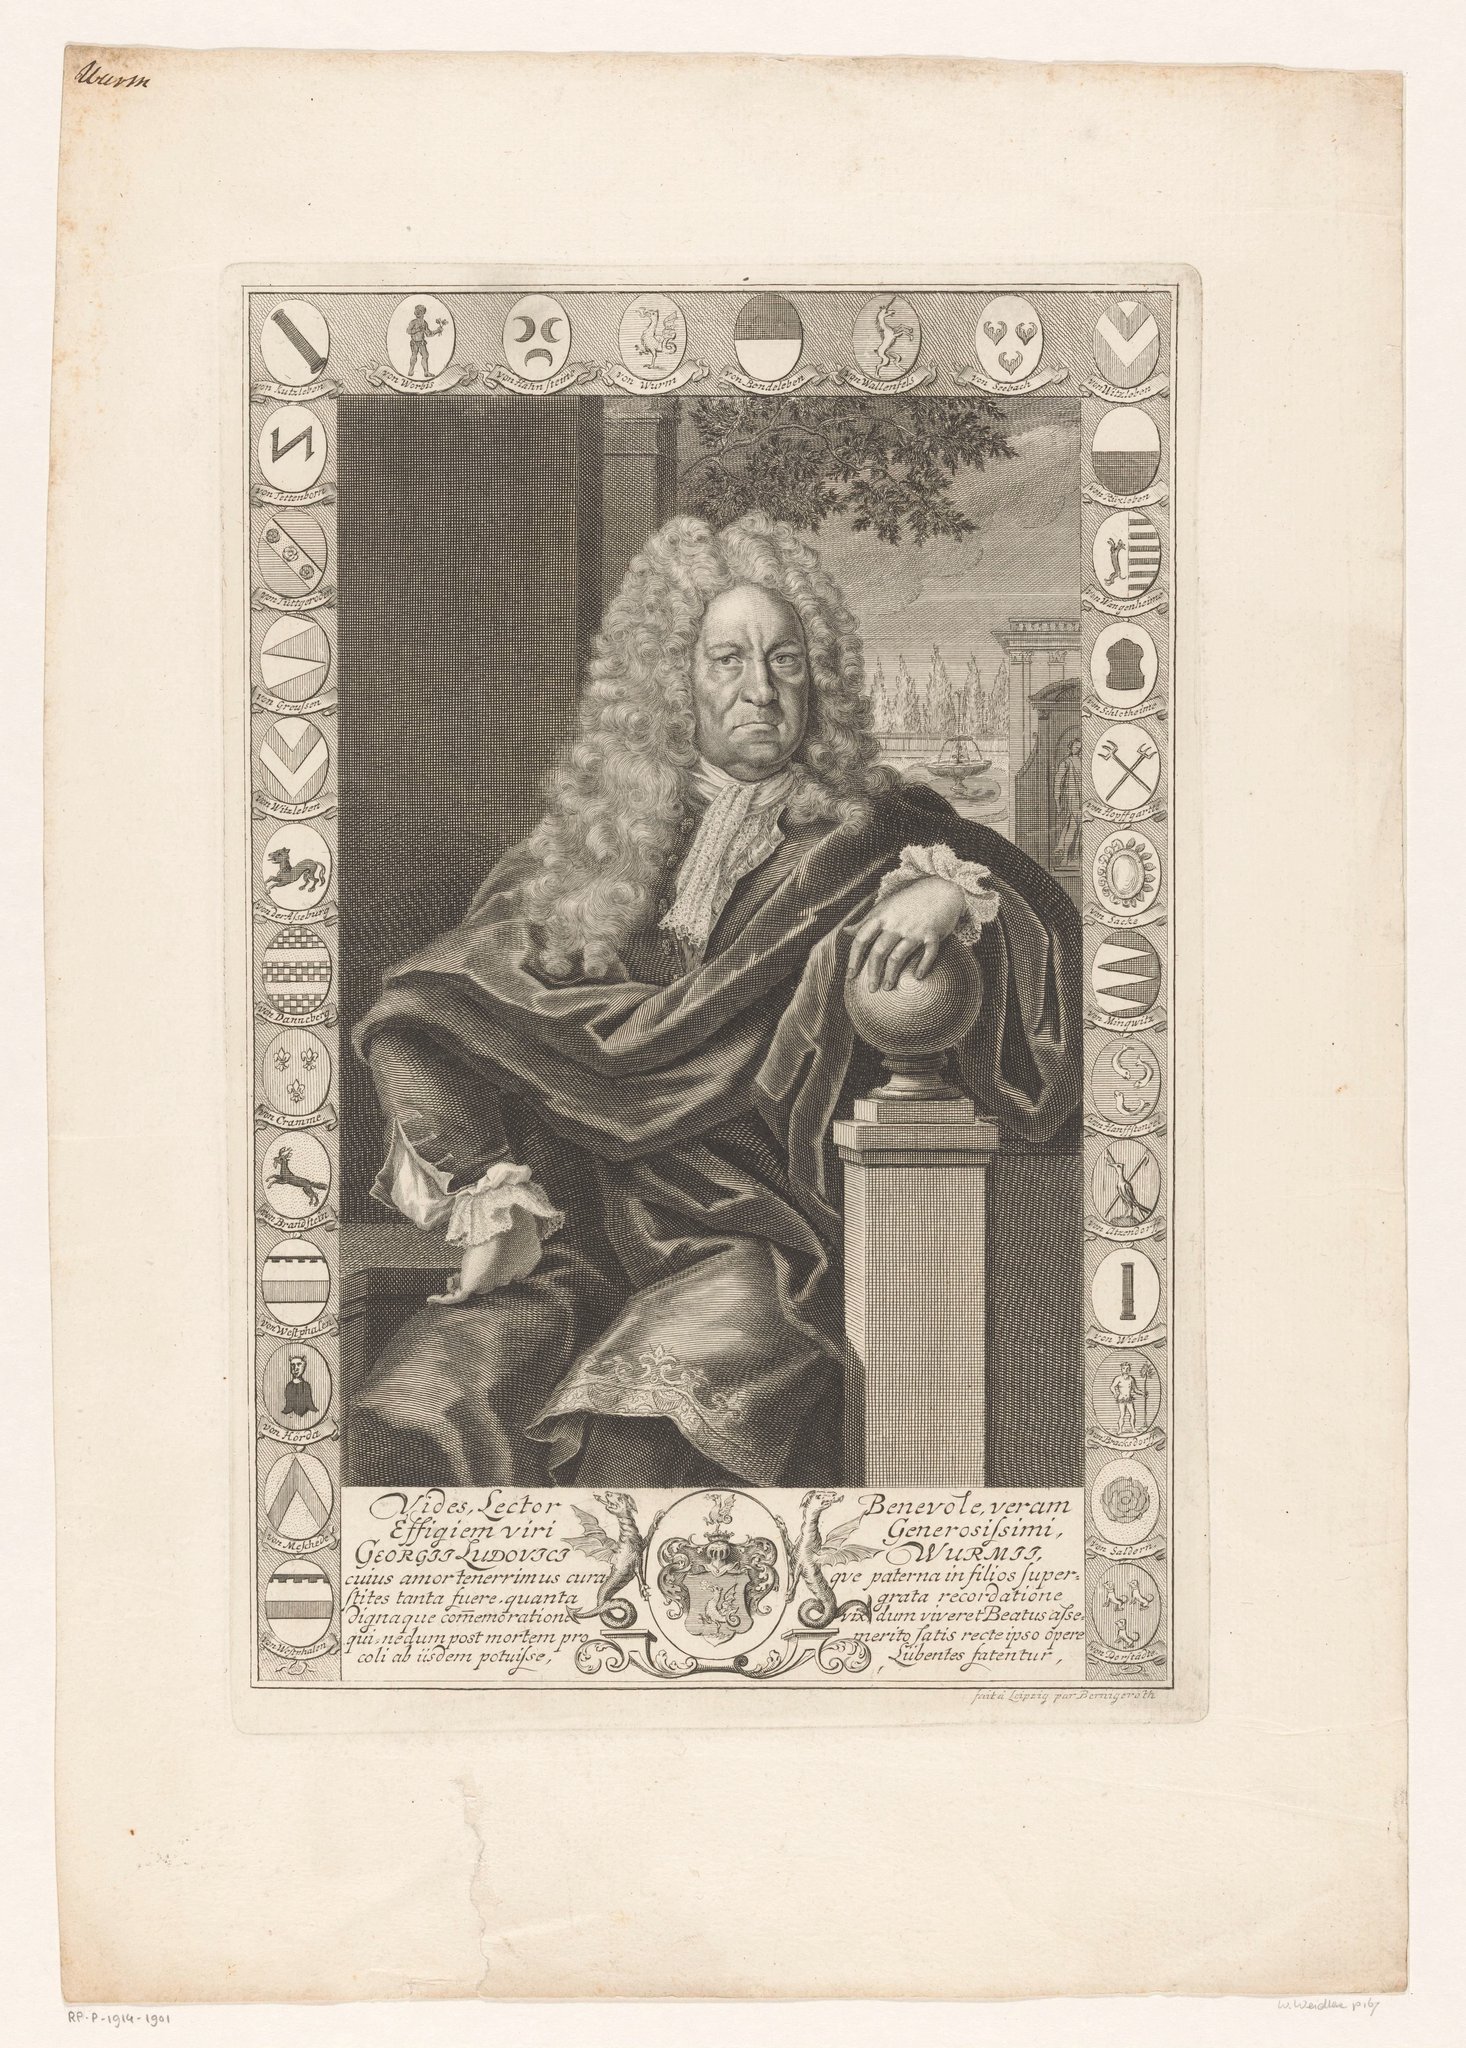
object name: print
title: Portret van Georg Ludwig von Wurmb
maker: martin bernigeroth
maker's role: print maker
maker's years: 1670-1733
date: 1721-1733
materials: paper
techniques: engraving, etching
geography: leipzig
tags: garden fountain, historical persons, armorial bearing, heraldry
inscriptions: collector's mark: Lugt 2228